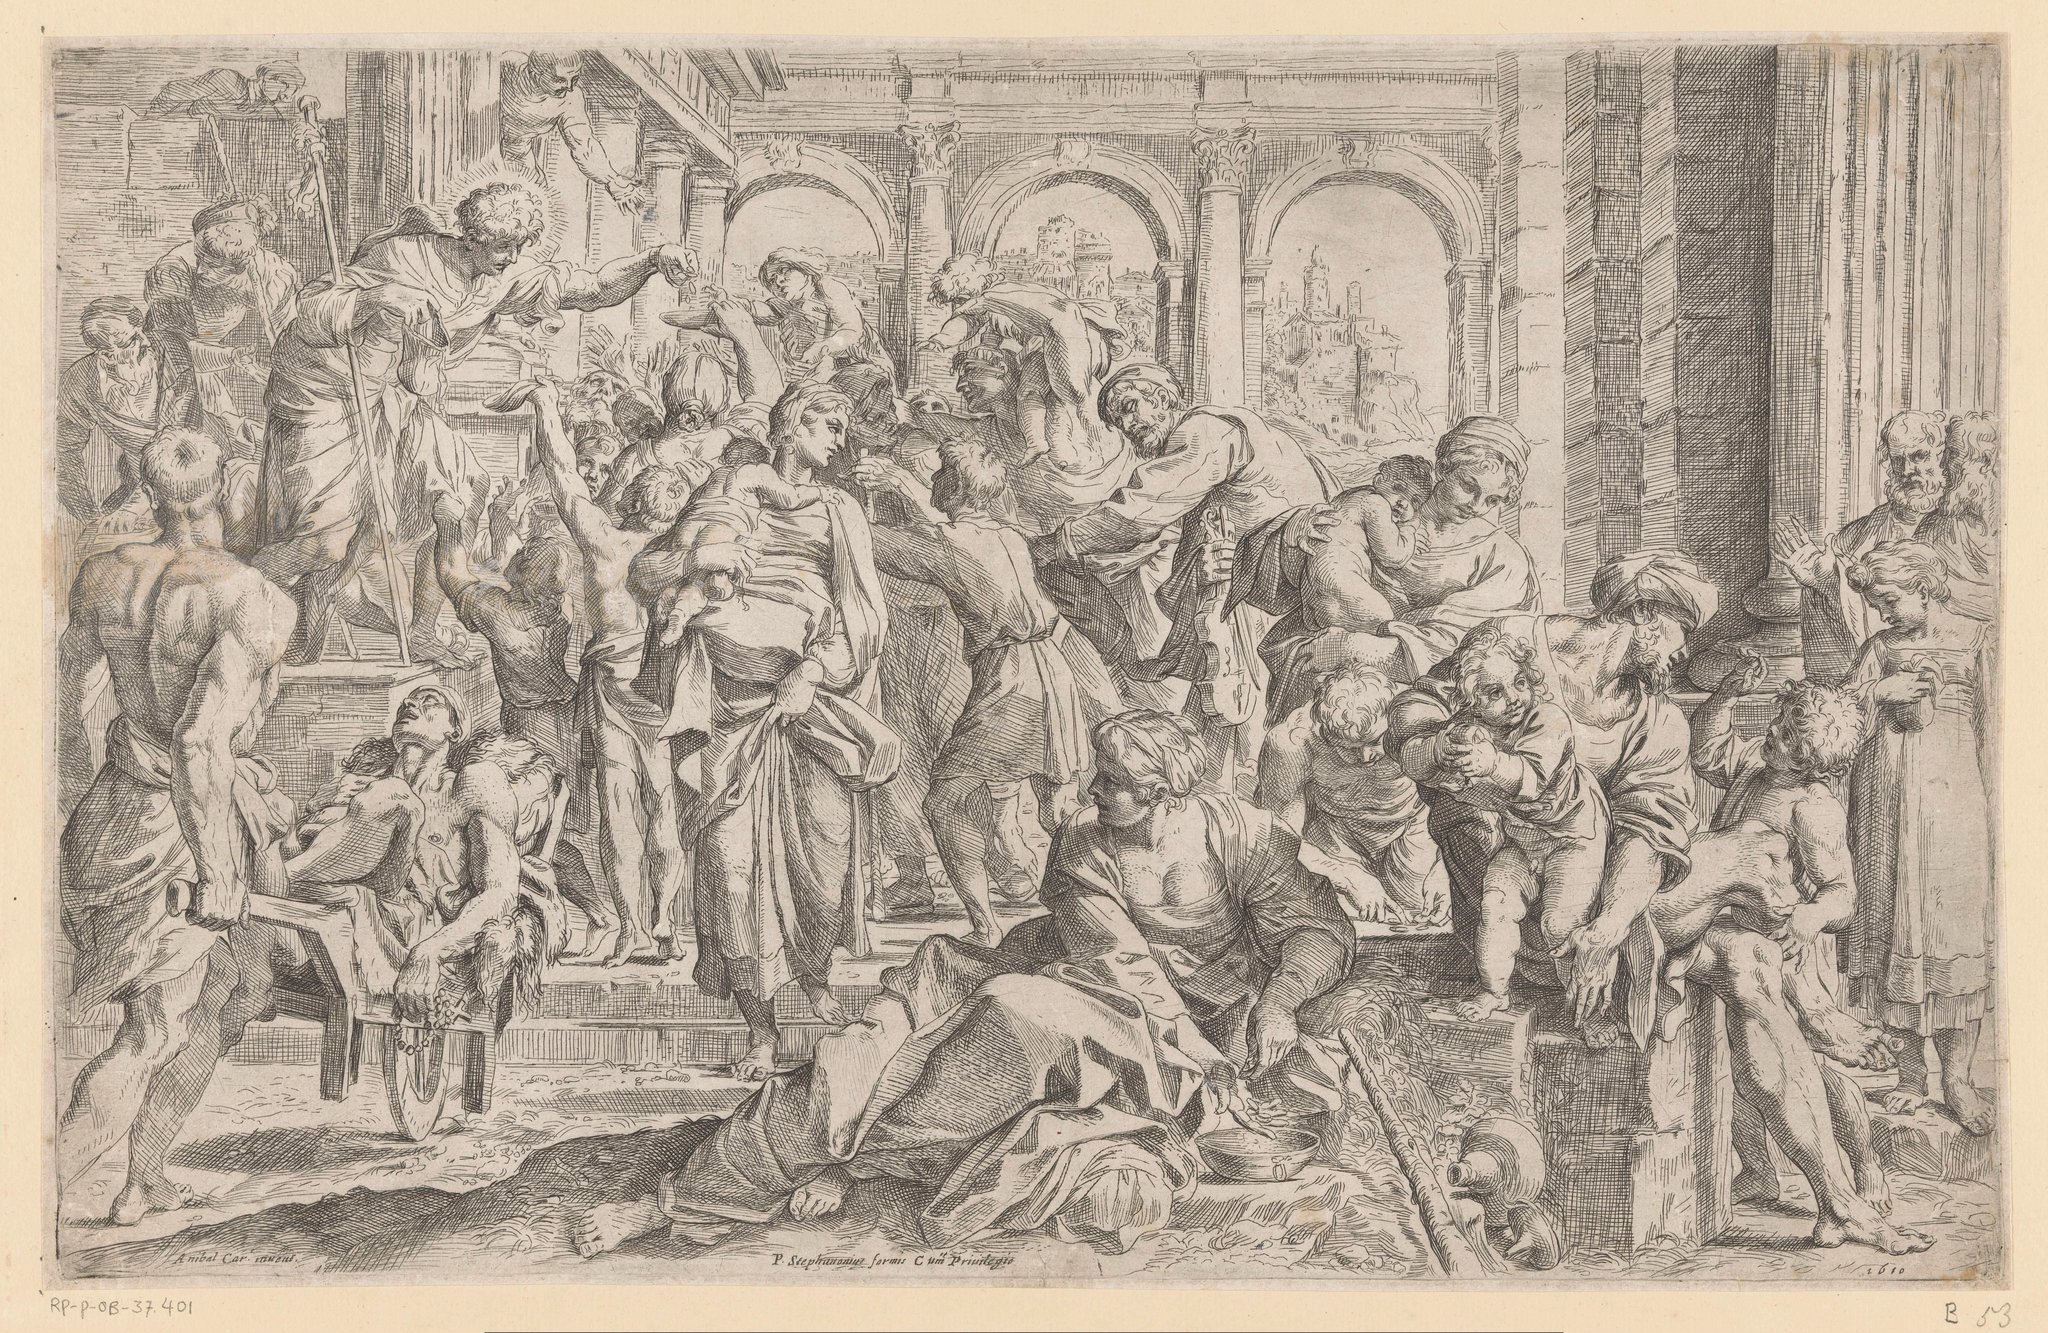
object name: print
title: Heilige Rochus verdeelt zijn rijkdommen onder de armen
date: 1610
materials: paper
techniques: engraving, etching, intaglio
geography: italy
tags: st. roch distributes his riches to the poor, and leaves on a pilgrimage, violin, fiddle, patient, sick person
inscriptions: inscription: ‘6,1. - 33.’, collector's mark: Lugt 240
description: In een binnenplaats staat links op een verhoging de heilige Rochus. Hij geeft munten aan een menigte die voor hem staat. In het midden een man met een viool en links een zieke liggend op een wagen.